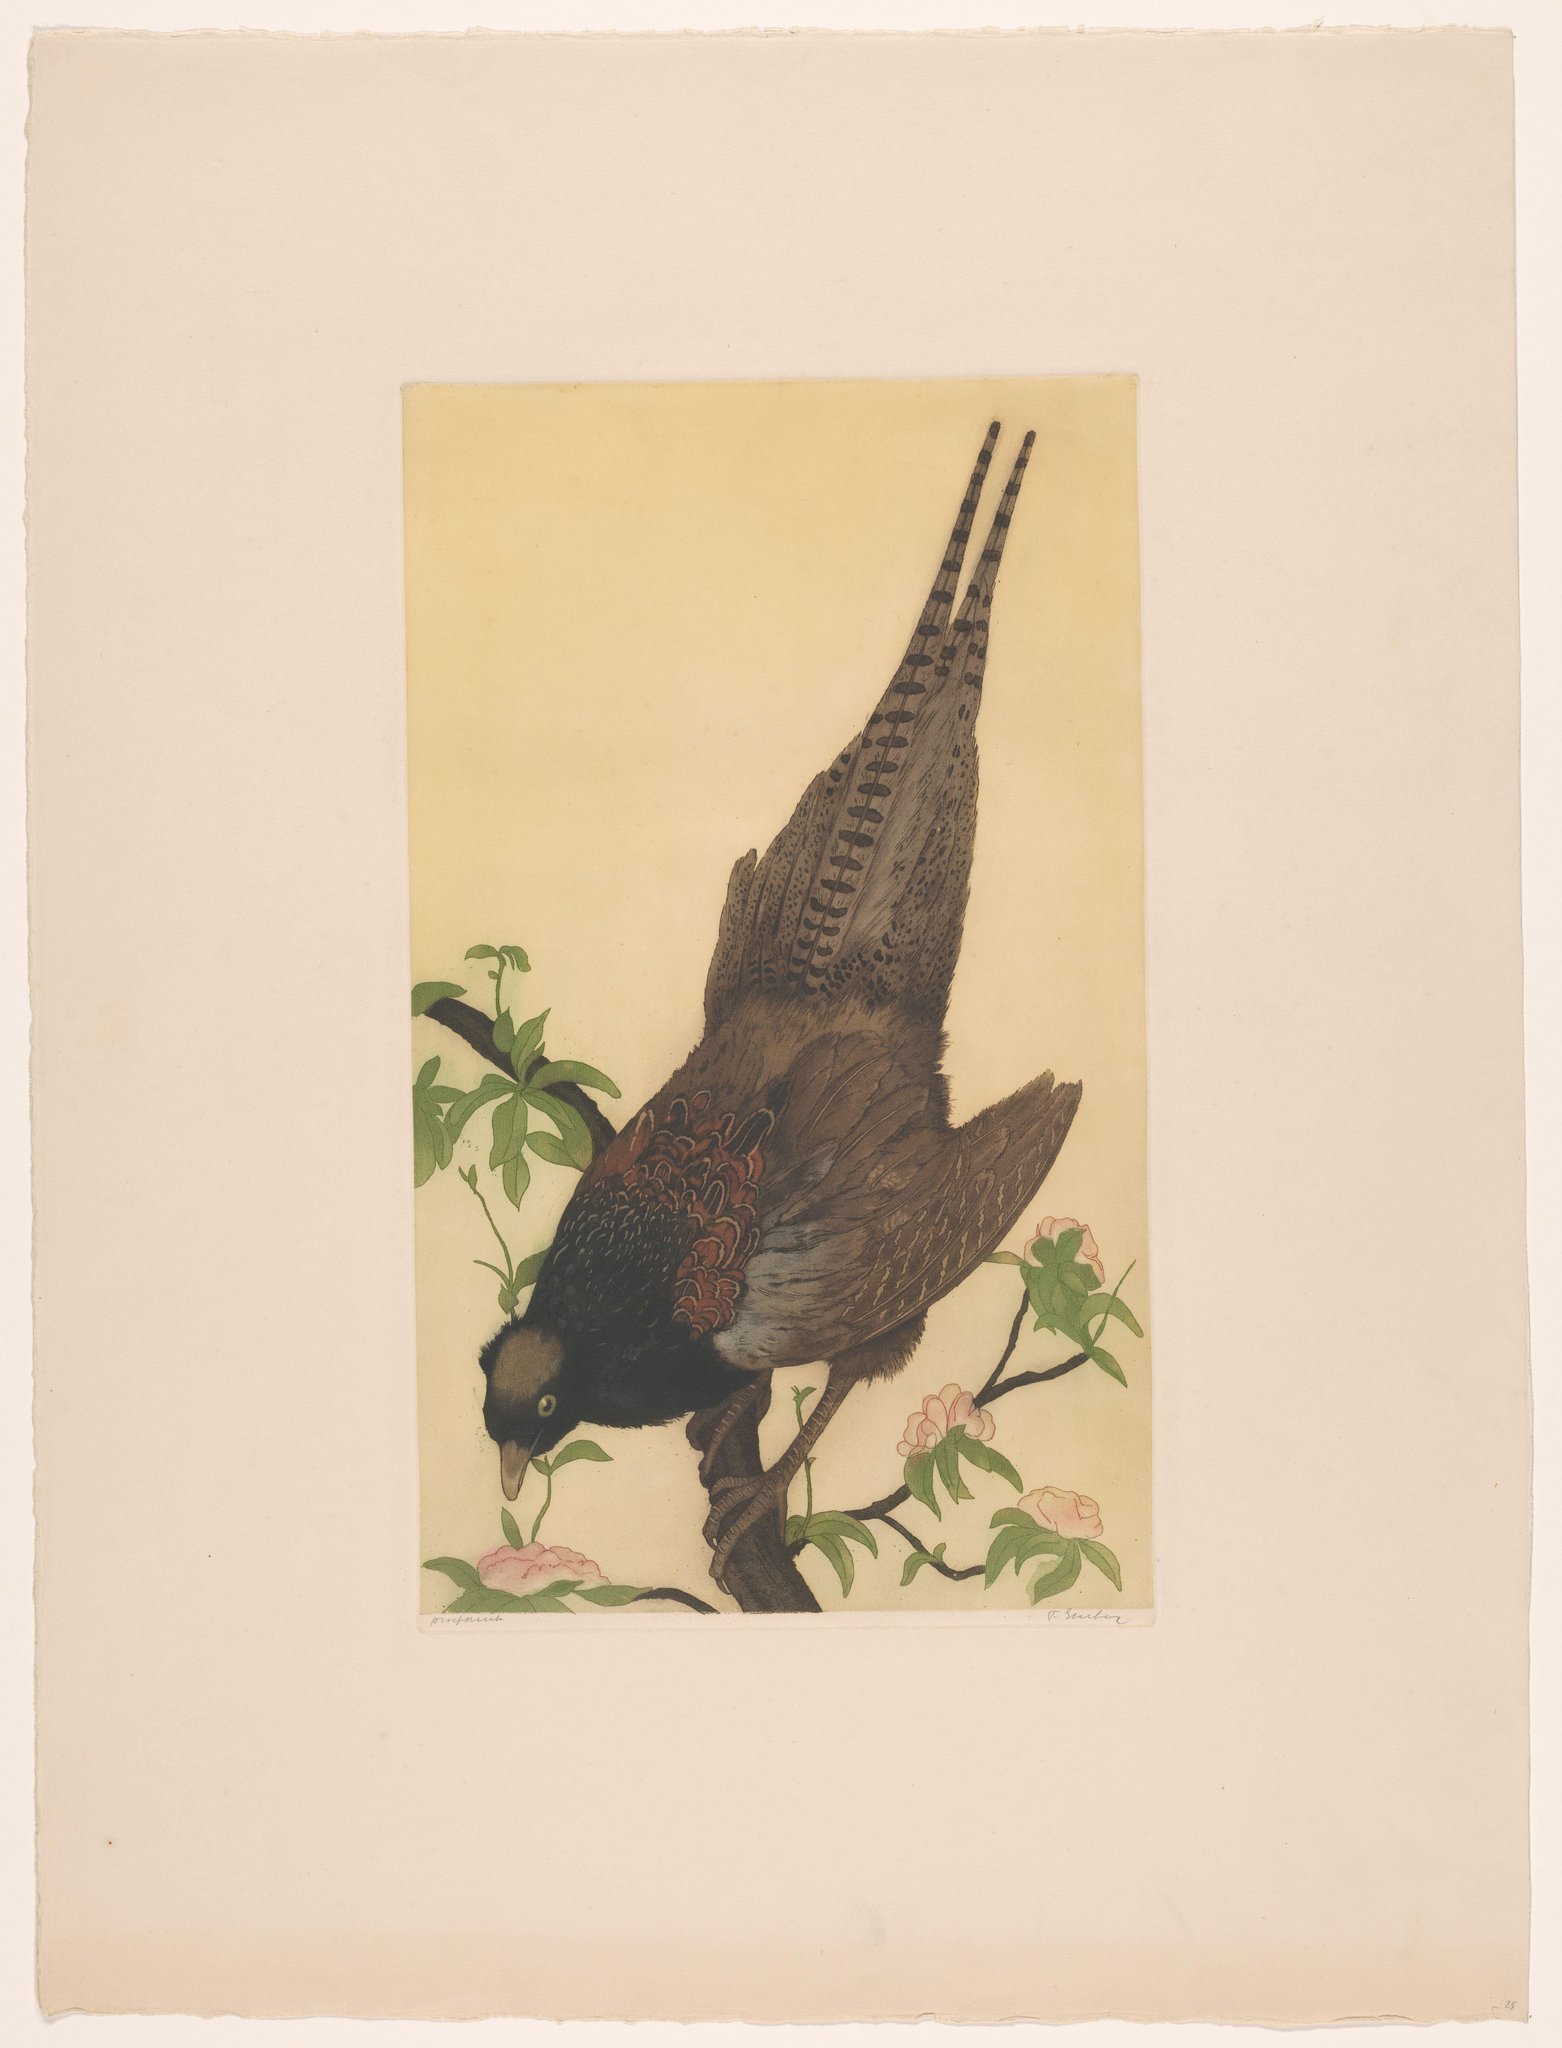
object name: print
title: Fazant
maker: frans everbag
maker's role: draughtsman, print maker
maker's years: 1877-1947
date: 1887-1931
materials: paper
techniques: aquatint, etching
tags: walker and runner birds: pheasant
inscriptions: collector's mark: Lugt 2228, inscription: ‘proefdruk’, watermark